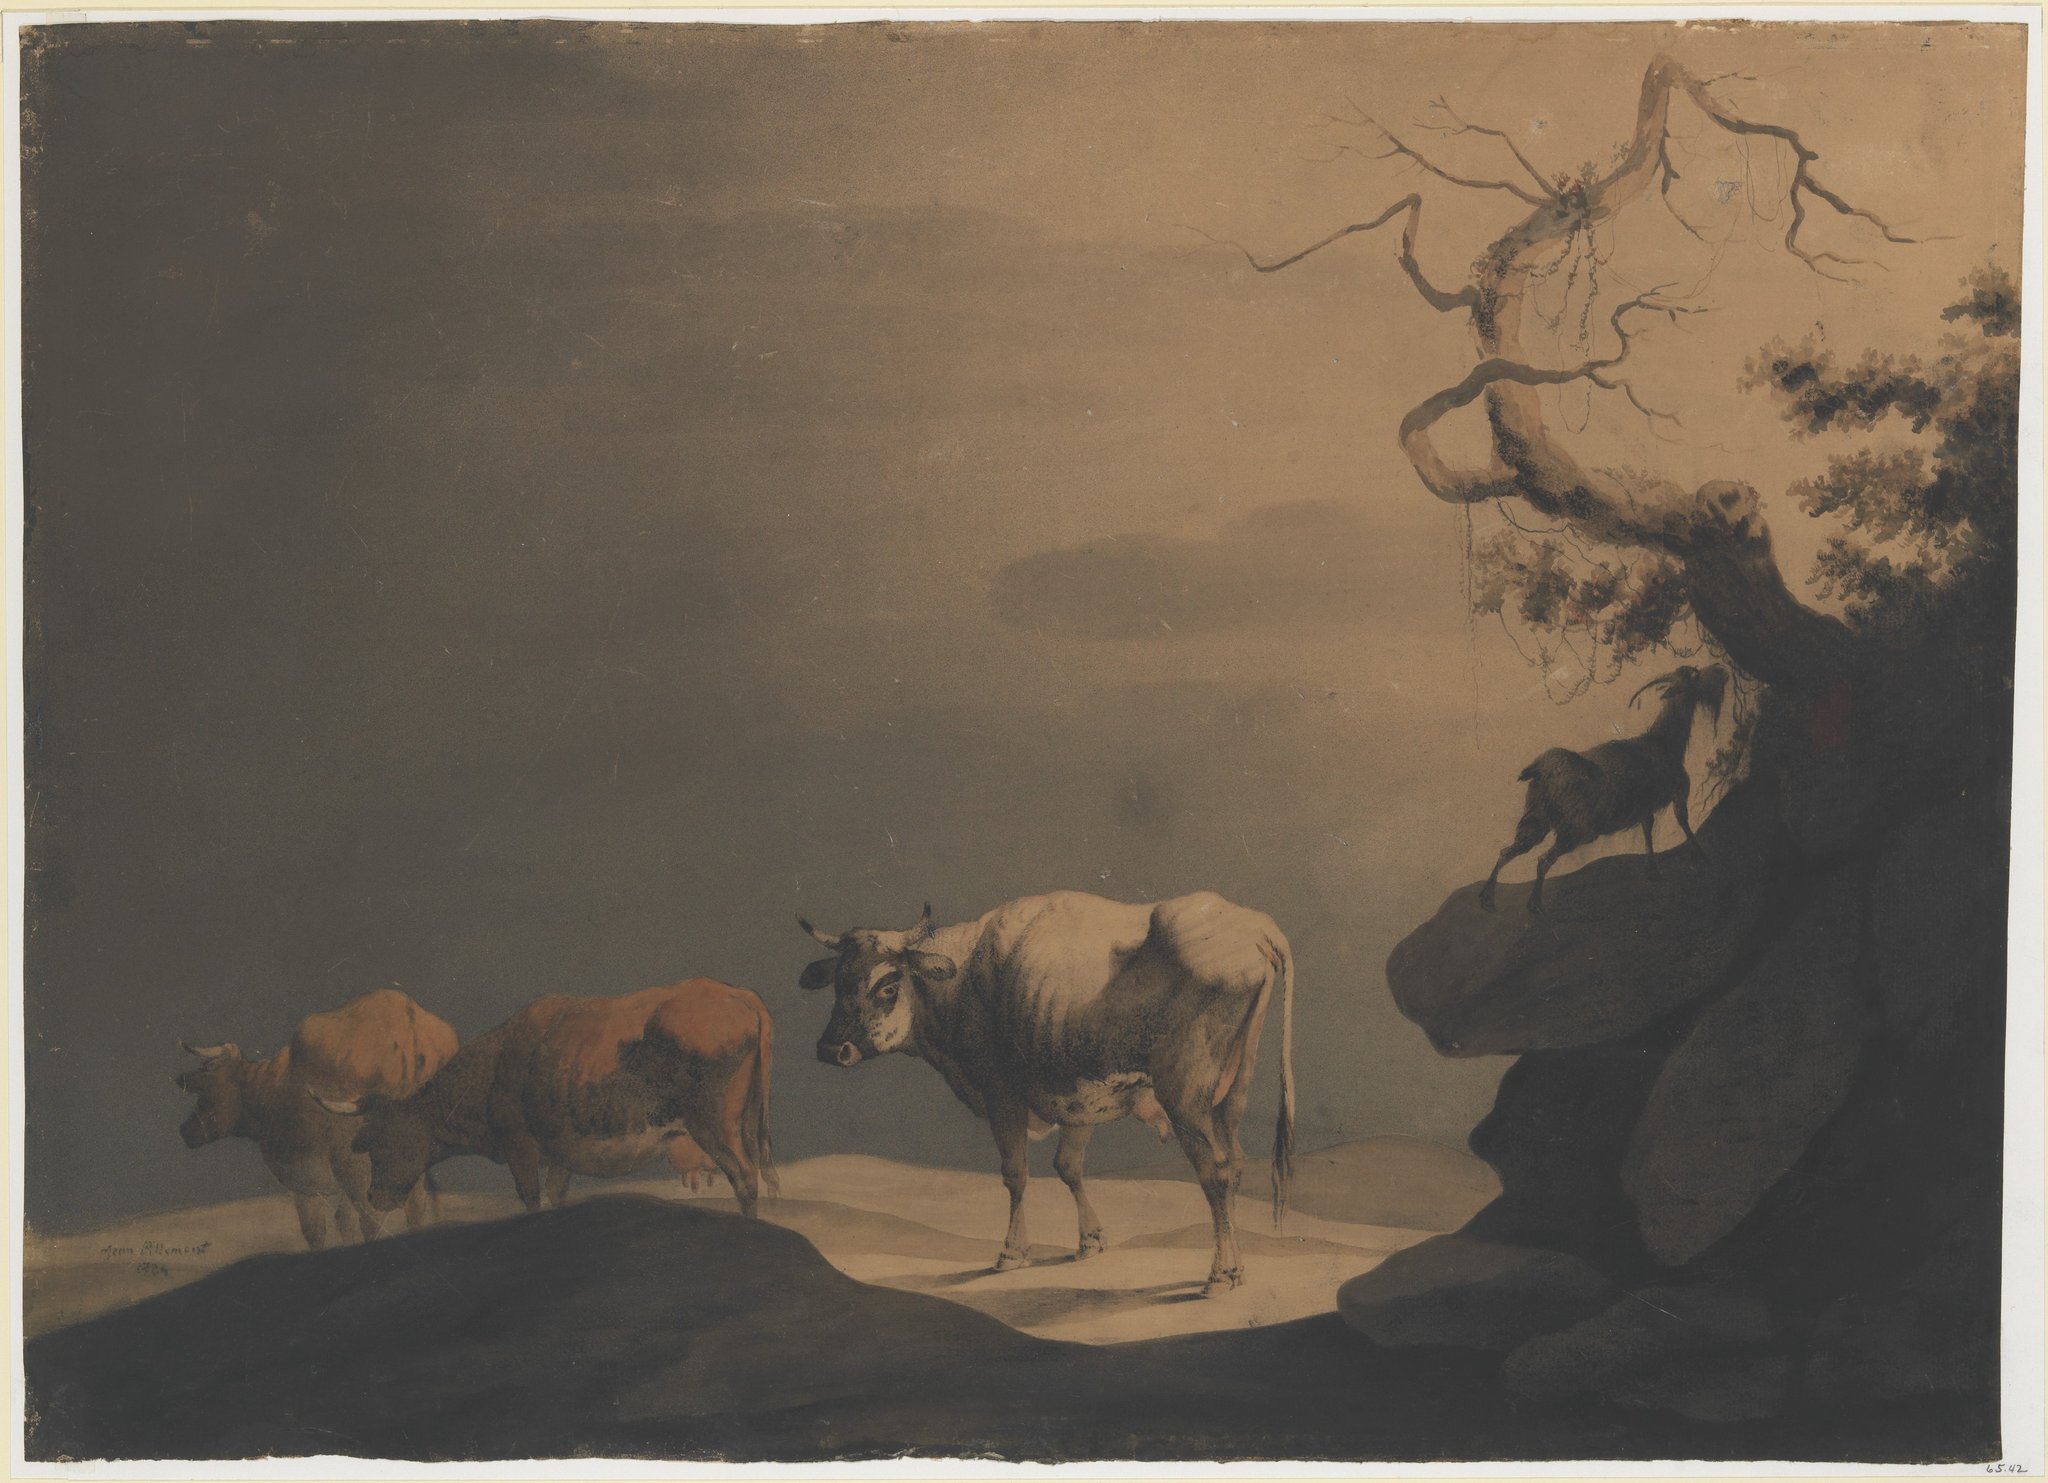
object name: drawing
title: Cows and a Goat in a Landscape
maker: jean pillement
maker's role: artist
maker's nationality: french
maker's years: 1728-1808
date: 1774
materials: gouache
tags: cows,goats,landscapes